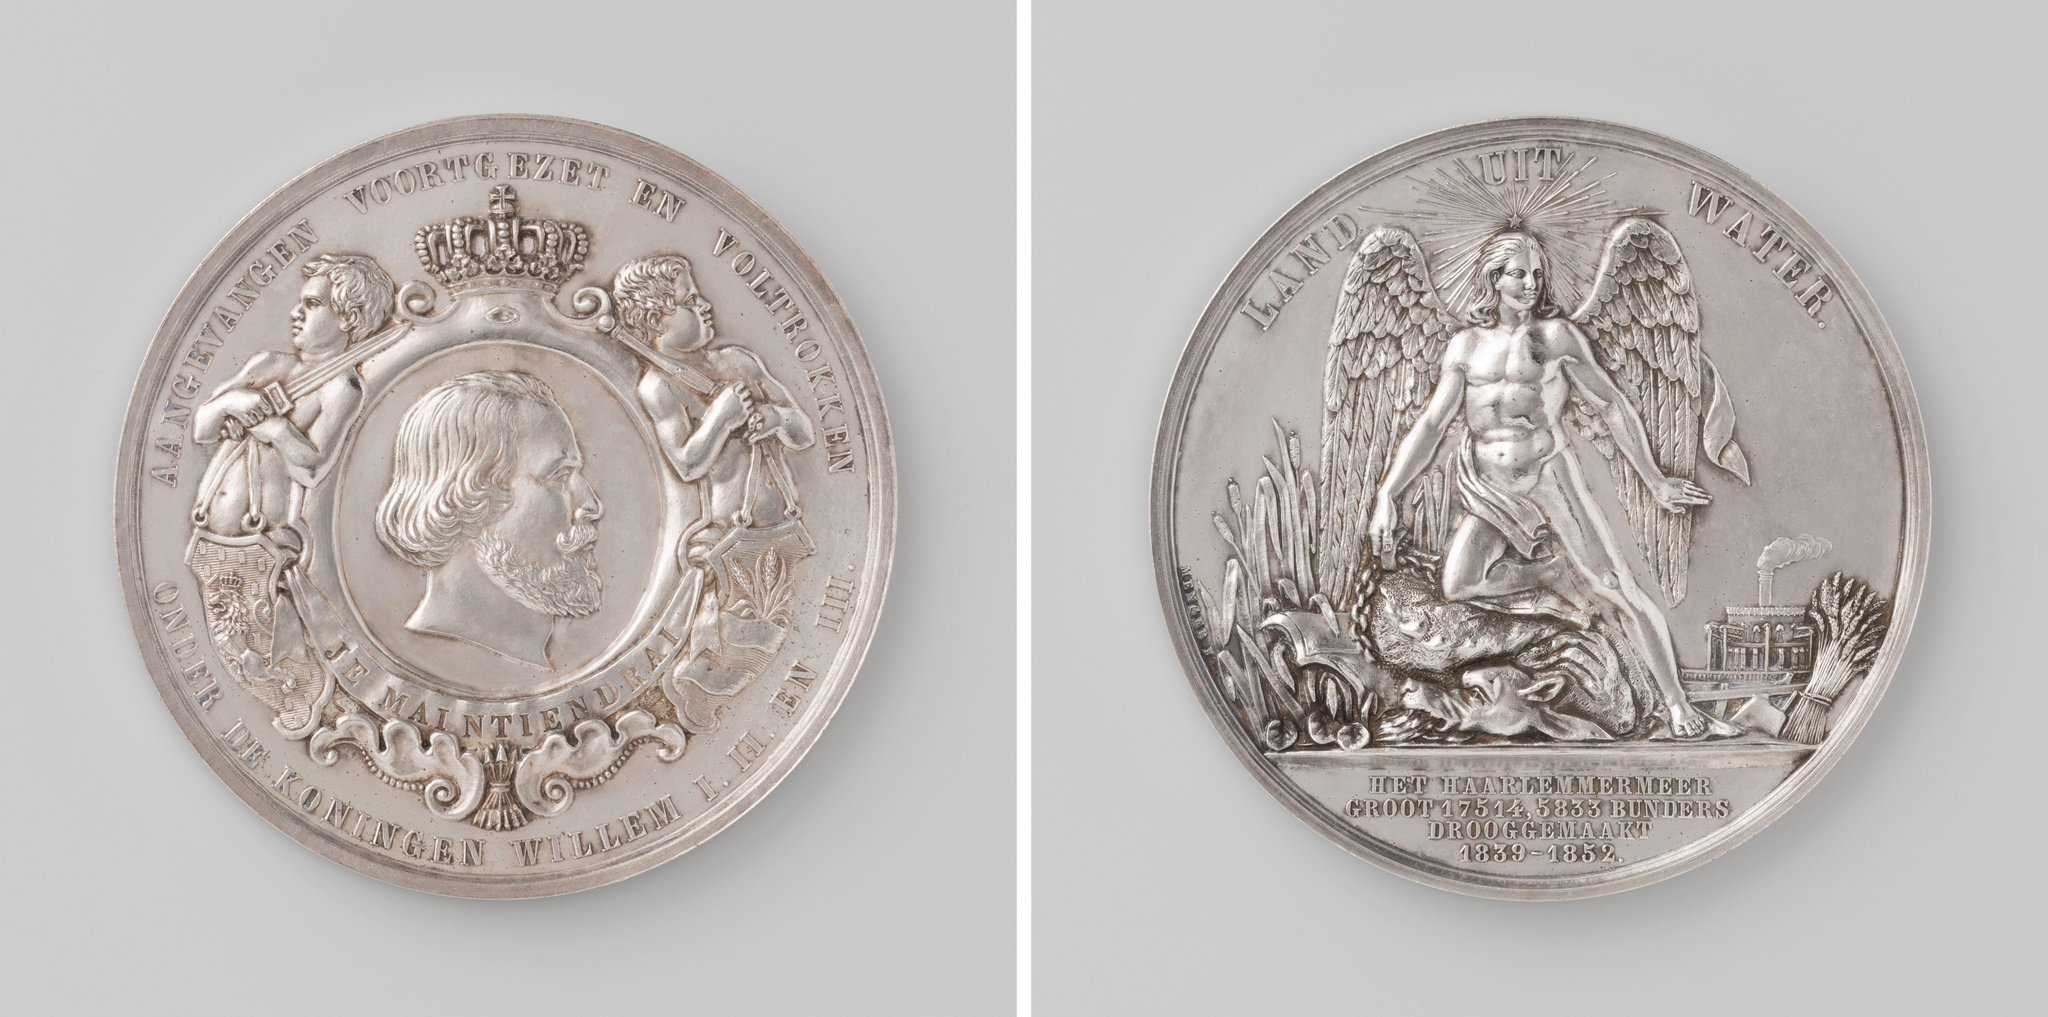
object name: history medal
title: Droogmaking van de Haarlemmermeer, ter ere van Willem III, koning der Nederlanden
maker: johan philip menger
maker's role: medailleur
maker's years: 1818-1895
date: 1853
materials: silver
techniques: striking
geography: utrecht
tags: william i of the netherlands, brussels, willem iii (koning der nederlanden), the hague, william ii of the netherlands